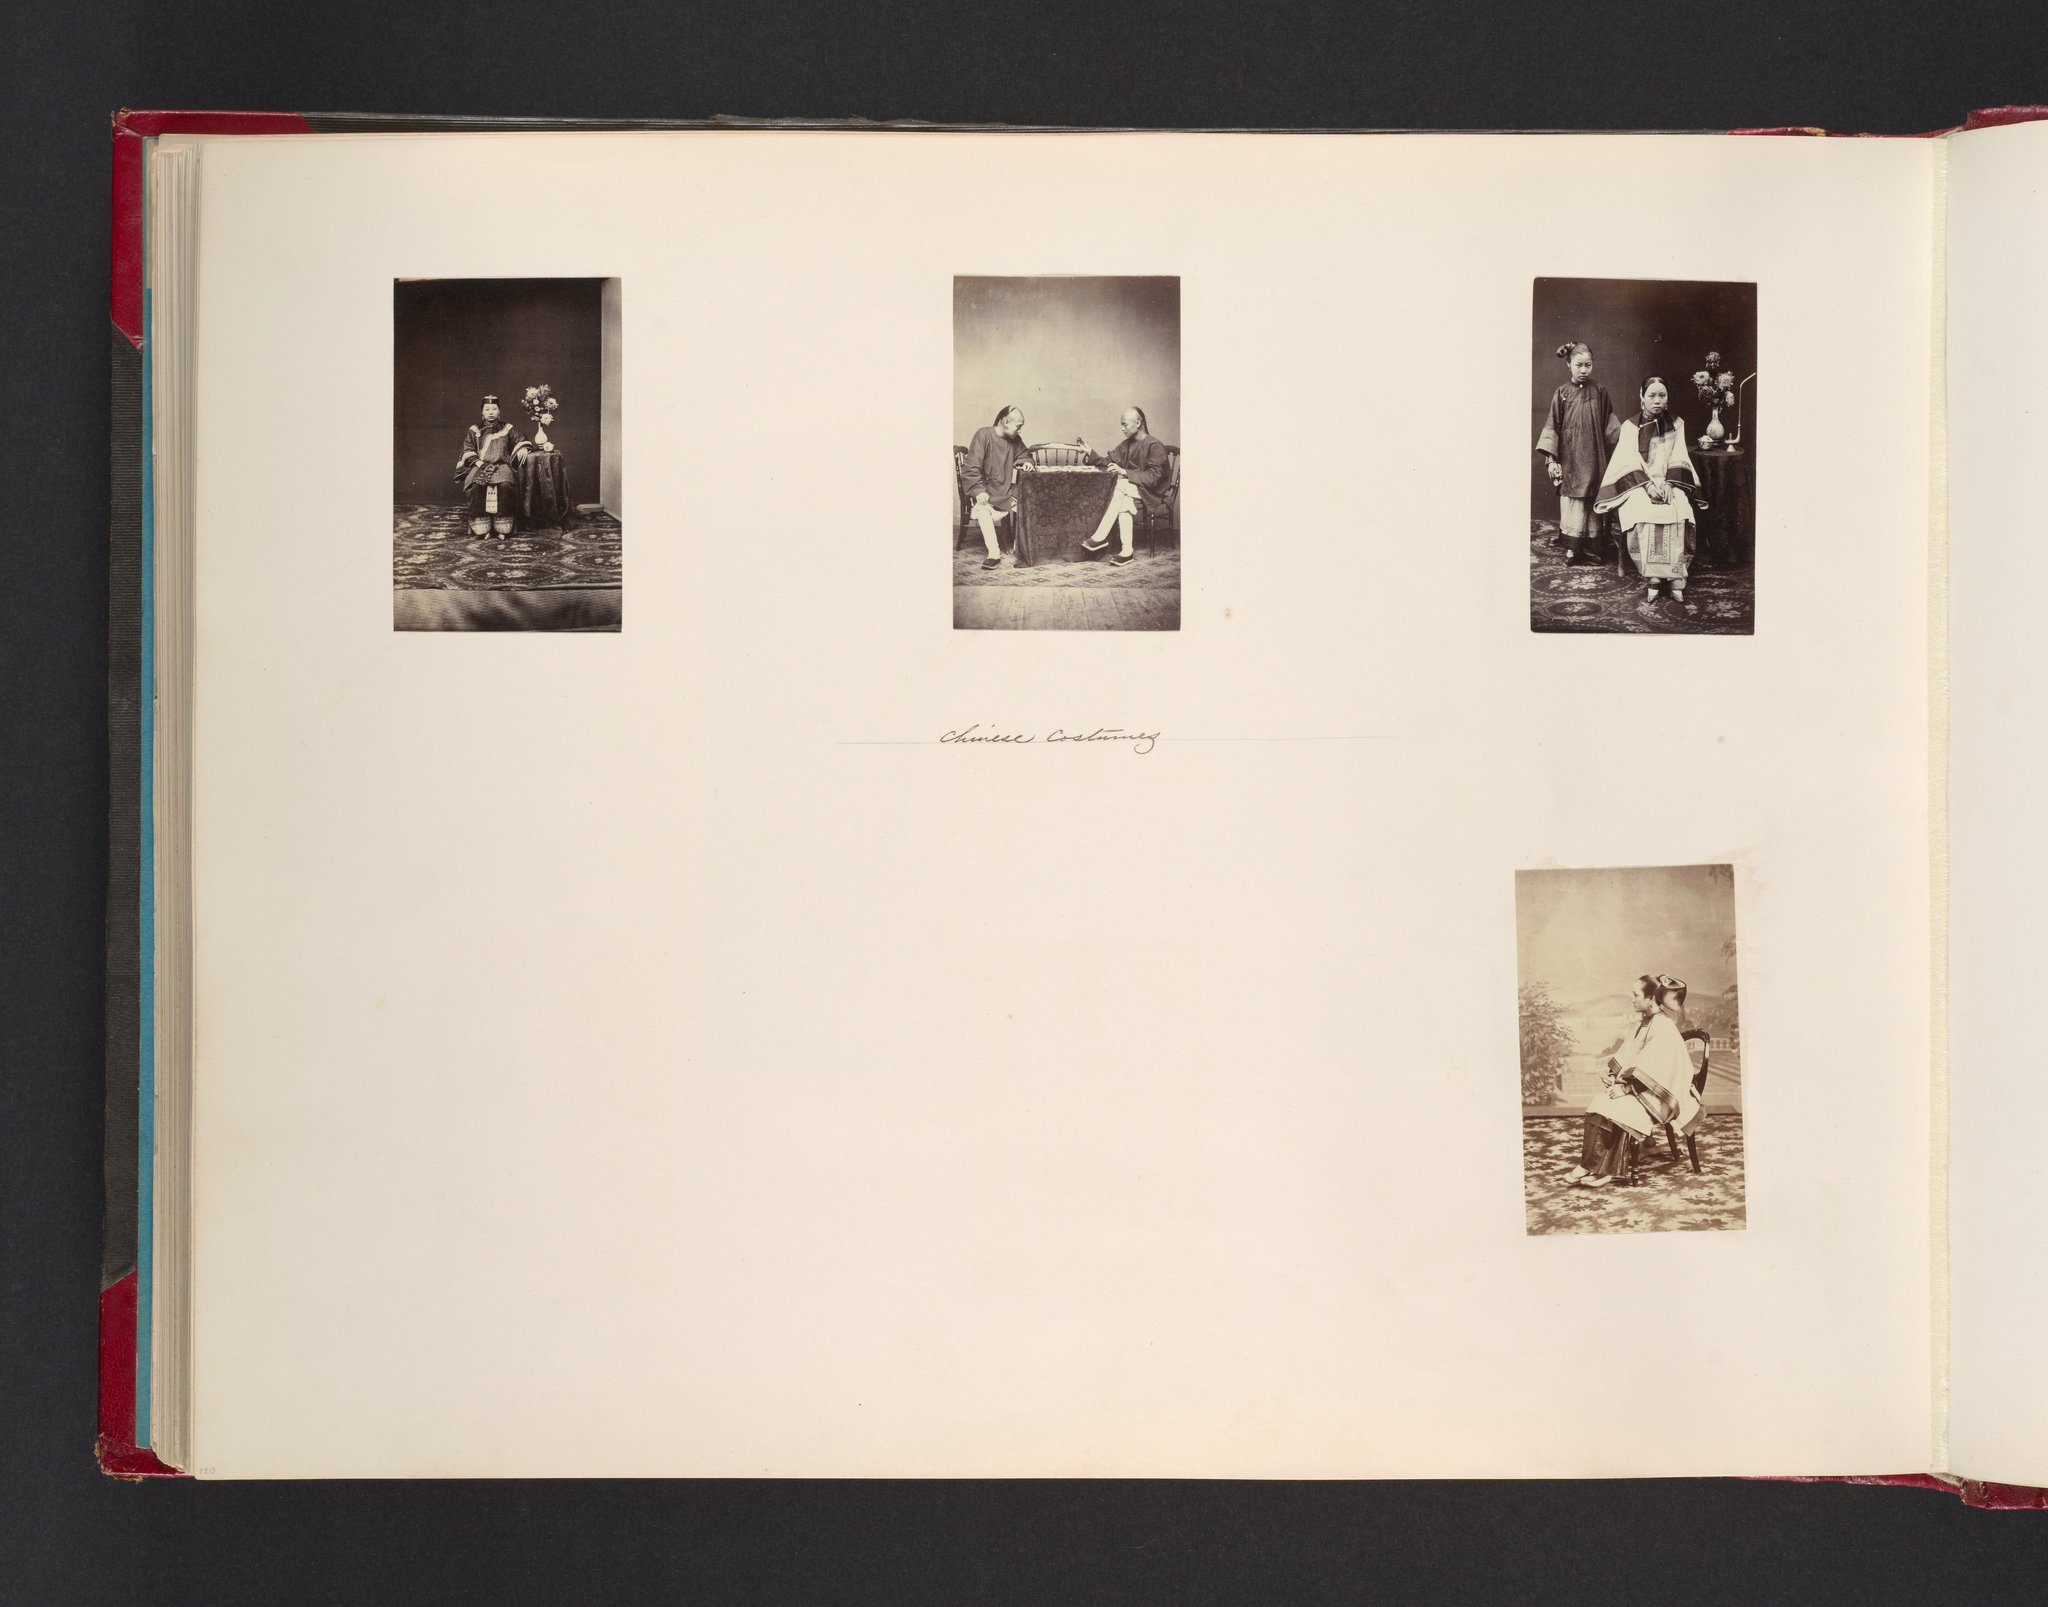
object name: photograph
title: Chinese Costumes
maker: john thomson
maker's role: artist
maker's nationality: british, scottish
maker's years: 1837-1921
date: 1865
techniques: albumen silver print, glass negative